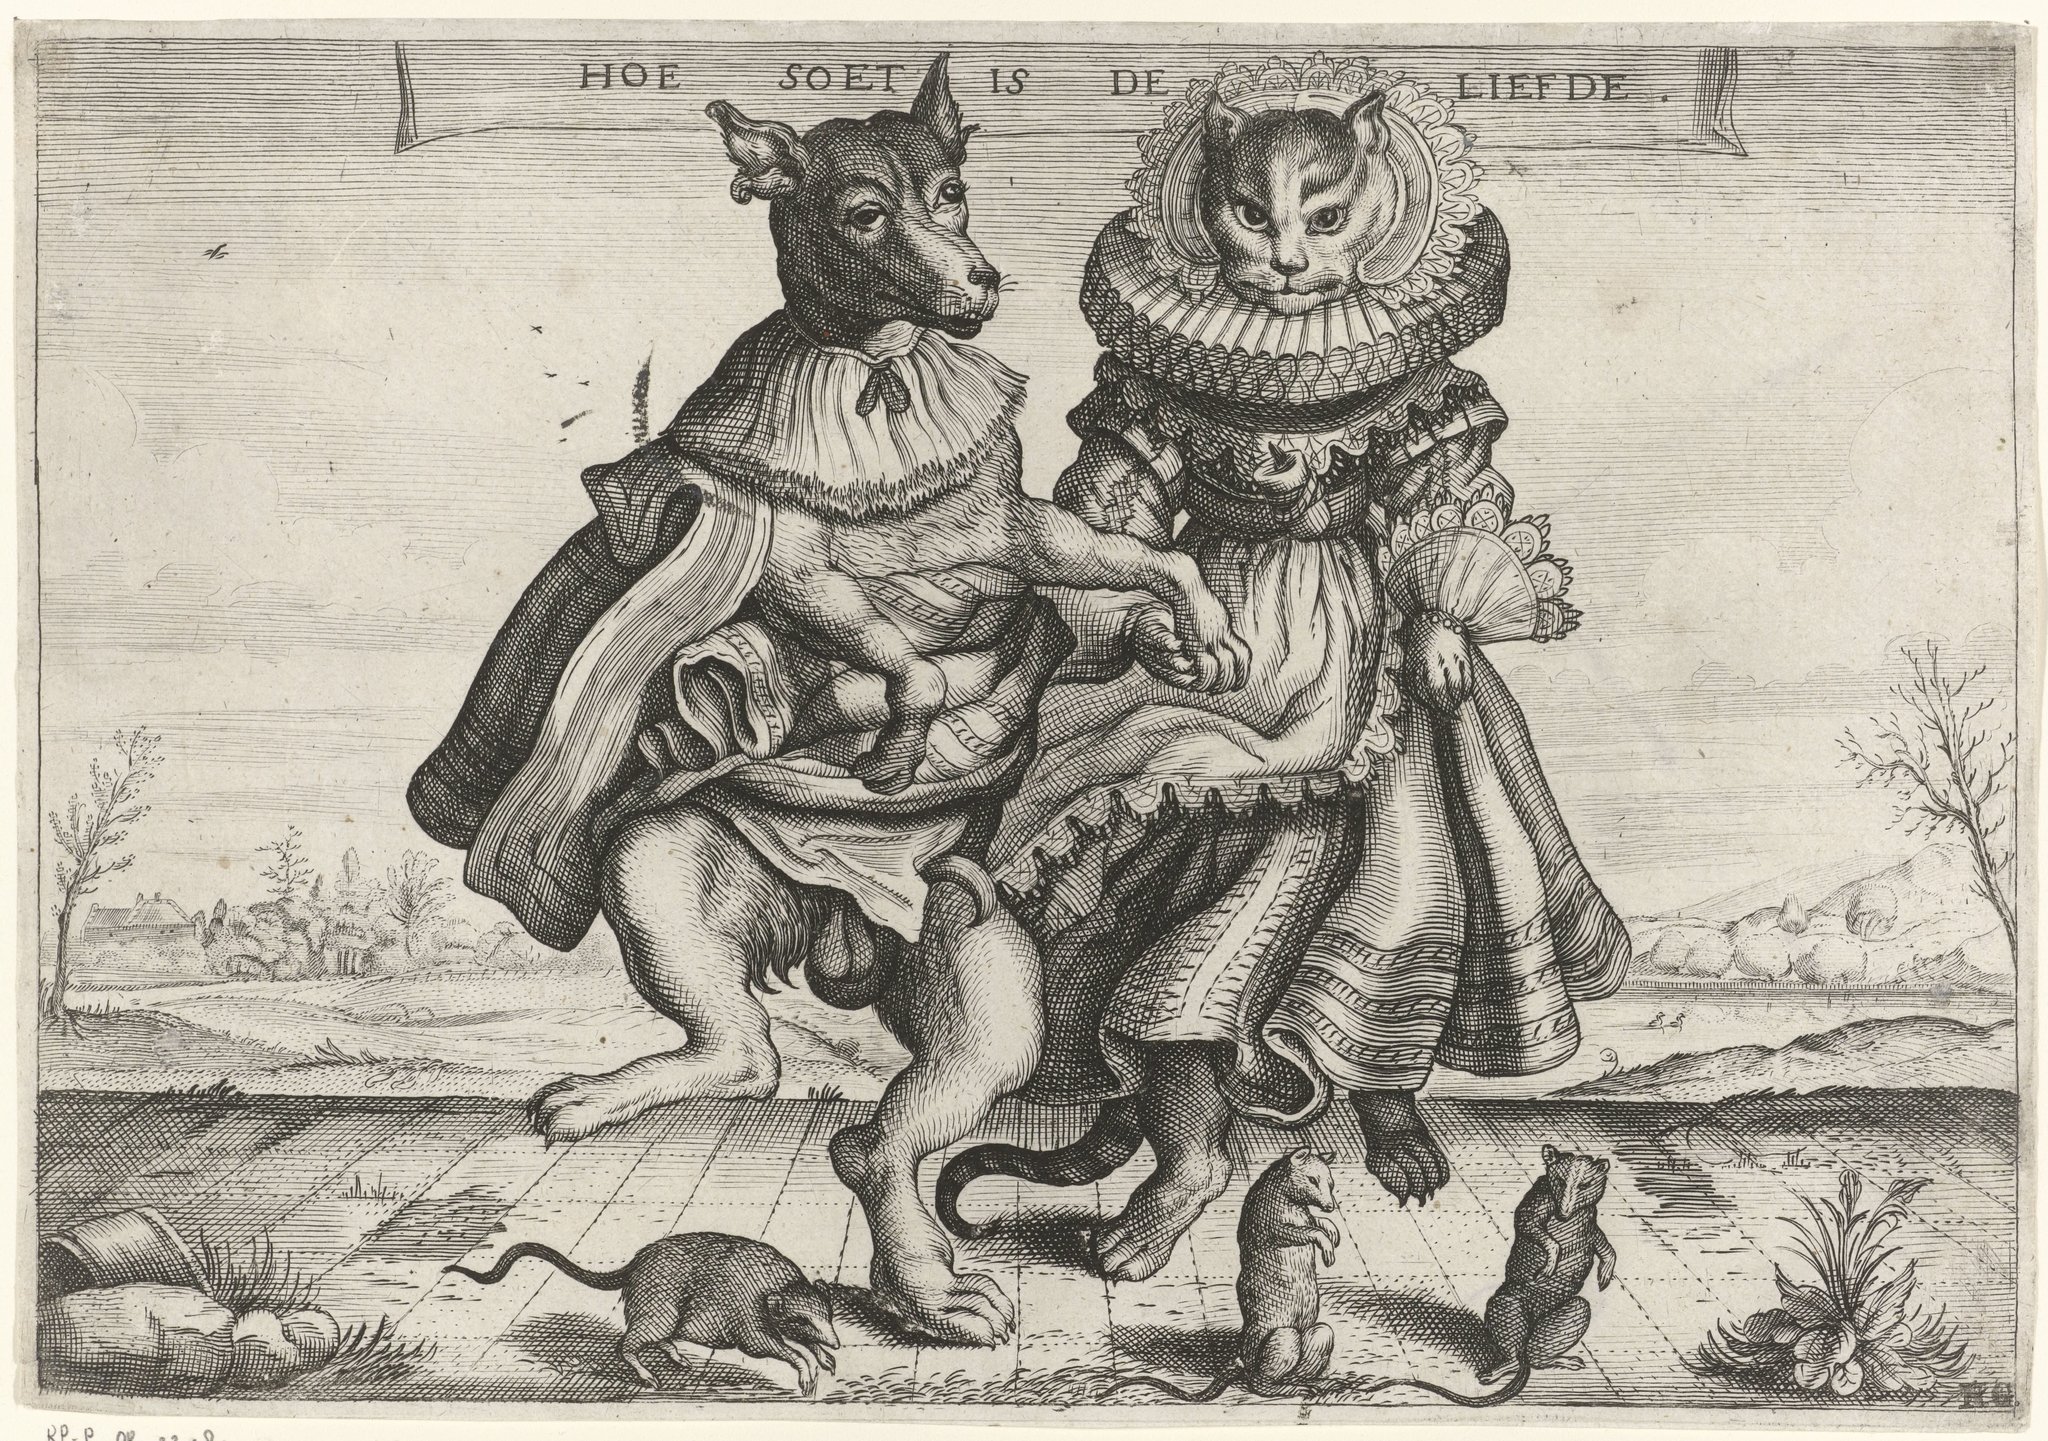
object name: print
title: Dansende hond en poes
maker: adriaen matham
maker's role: draughtsman, print maker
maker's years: 1599-1660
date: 1620-1660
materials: paper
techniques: engraving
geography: northern netherlands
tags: rodents: rat, cat, cape (+ men's clothes), animals acting as human beings, one pair dancing; man and woman dancing as a couple, neck-gear ~ clothing (with name) (+ women's clothes), dress, gown (+ women's clothes), neck-gear: collar (+ men's clothes), dog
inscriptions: collector's mark: Lugt 1967, collector's mark: Lugt 2228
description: Een hond en een poes, als mensen gekleed volgens de mode van ca. 1615. Drie muizen dansen voor hun voeten.